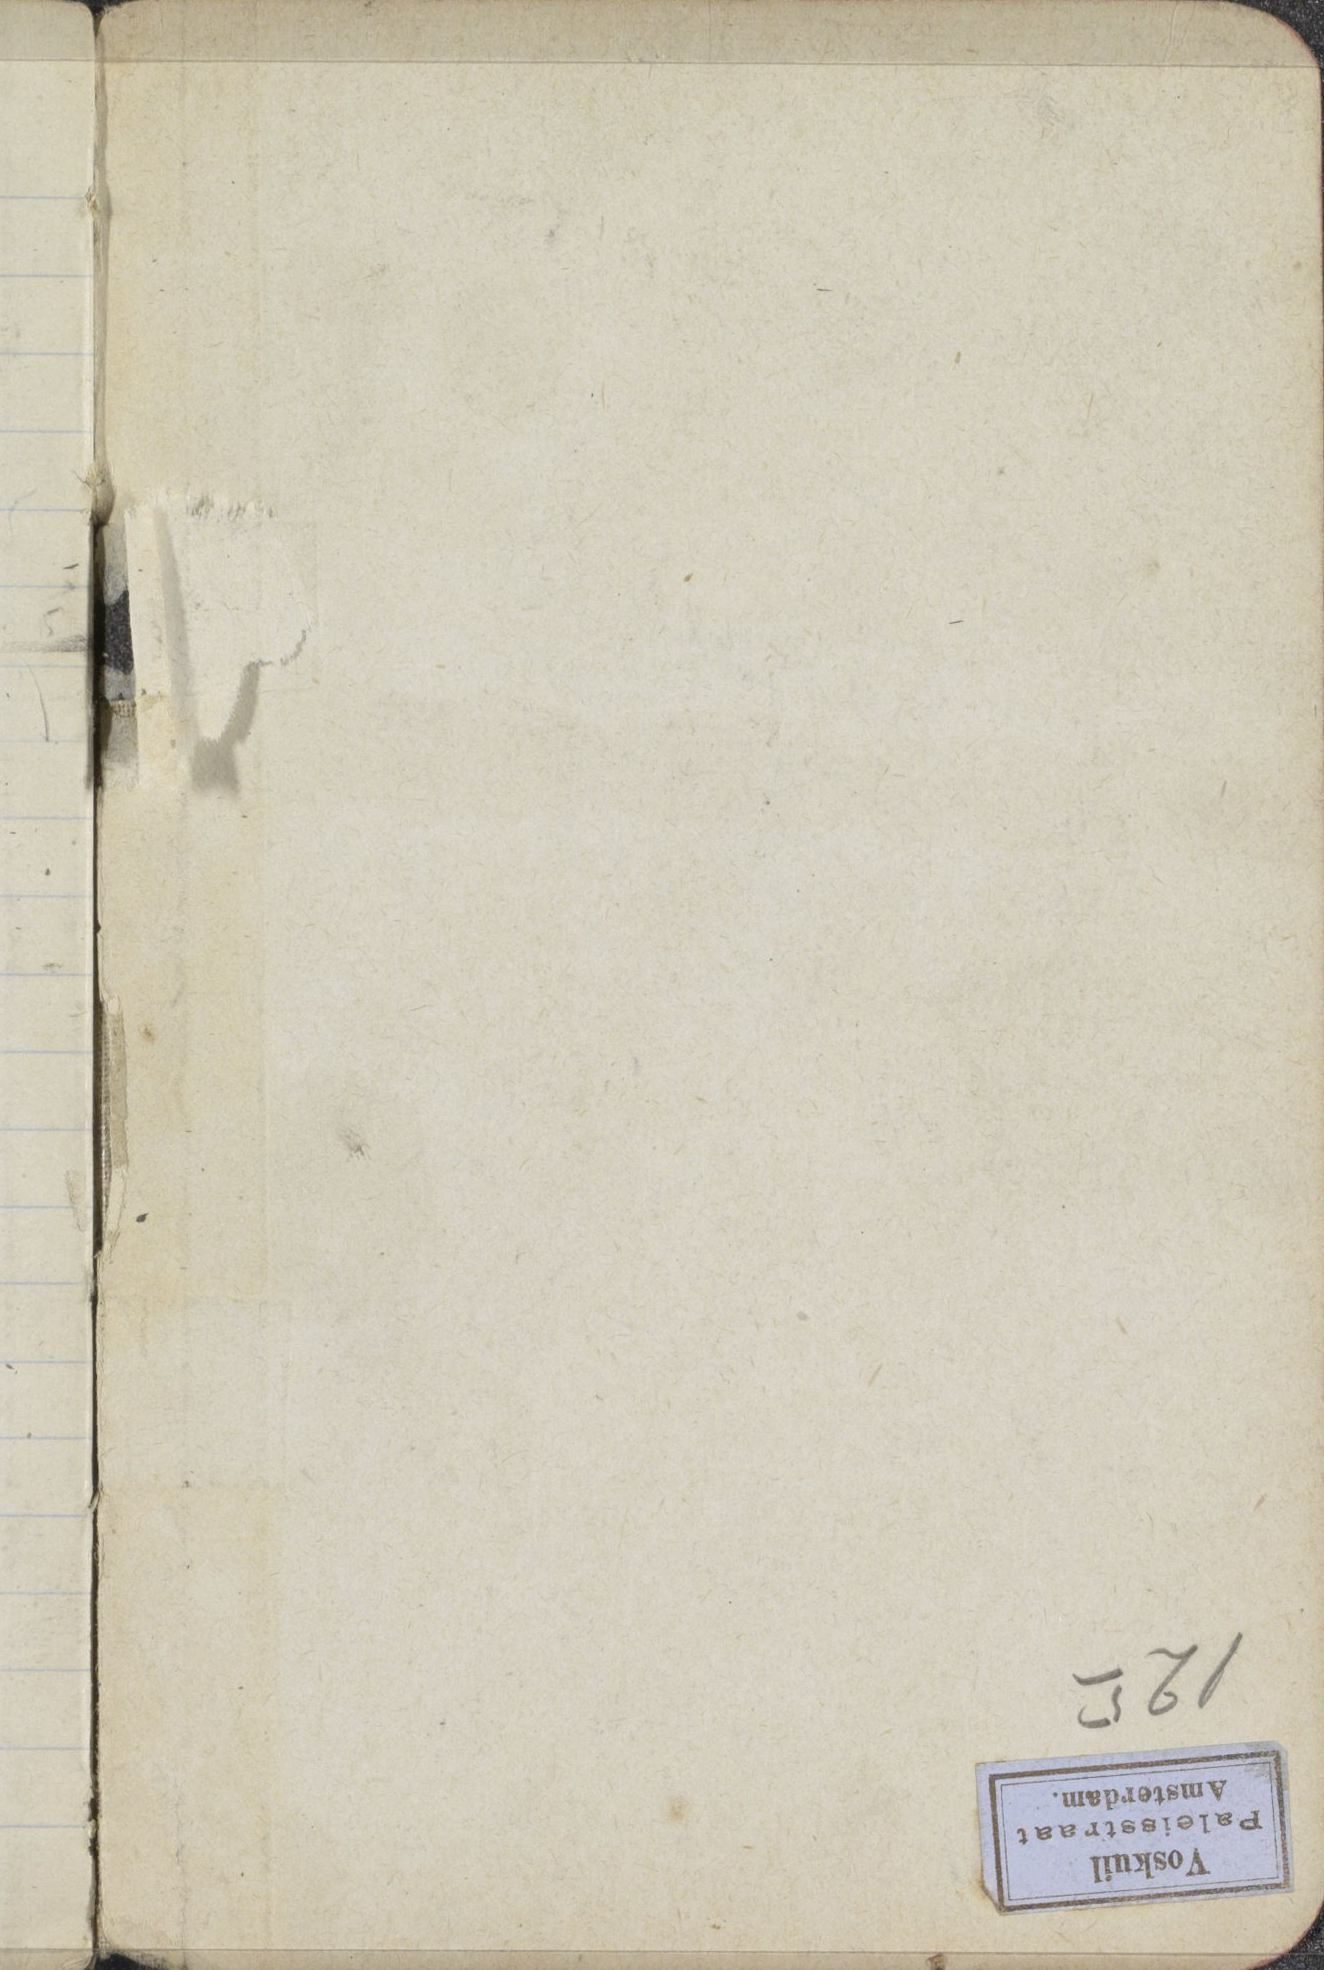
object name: sketchbook leaf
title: Annotatie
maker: george hendrik breitner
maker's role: draughtsman, painter, print maker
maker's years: 1857-1923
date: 1890-1900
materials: pencil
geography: amsterdam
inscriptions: annotation: ‘12/5’, retailer's mark: ‘Voskuil/ Paleisstraat/ Amsterdam.’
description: Pagina 68 uit een schetsboek met 33 bladen.